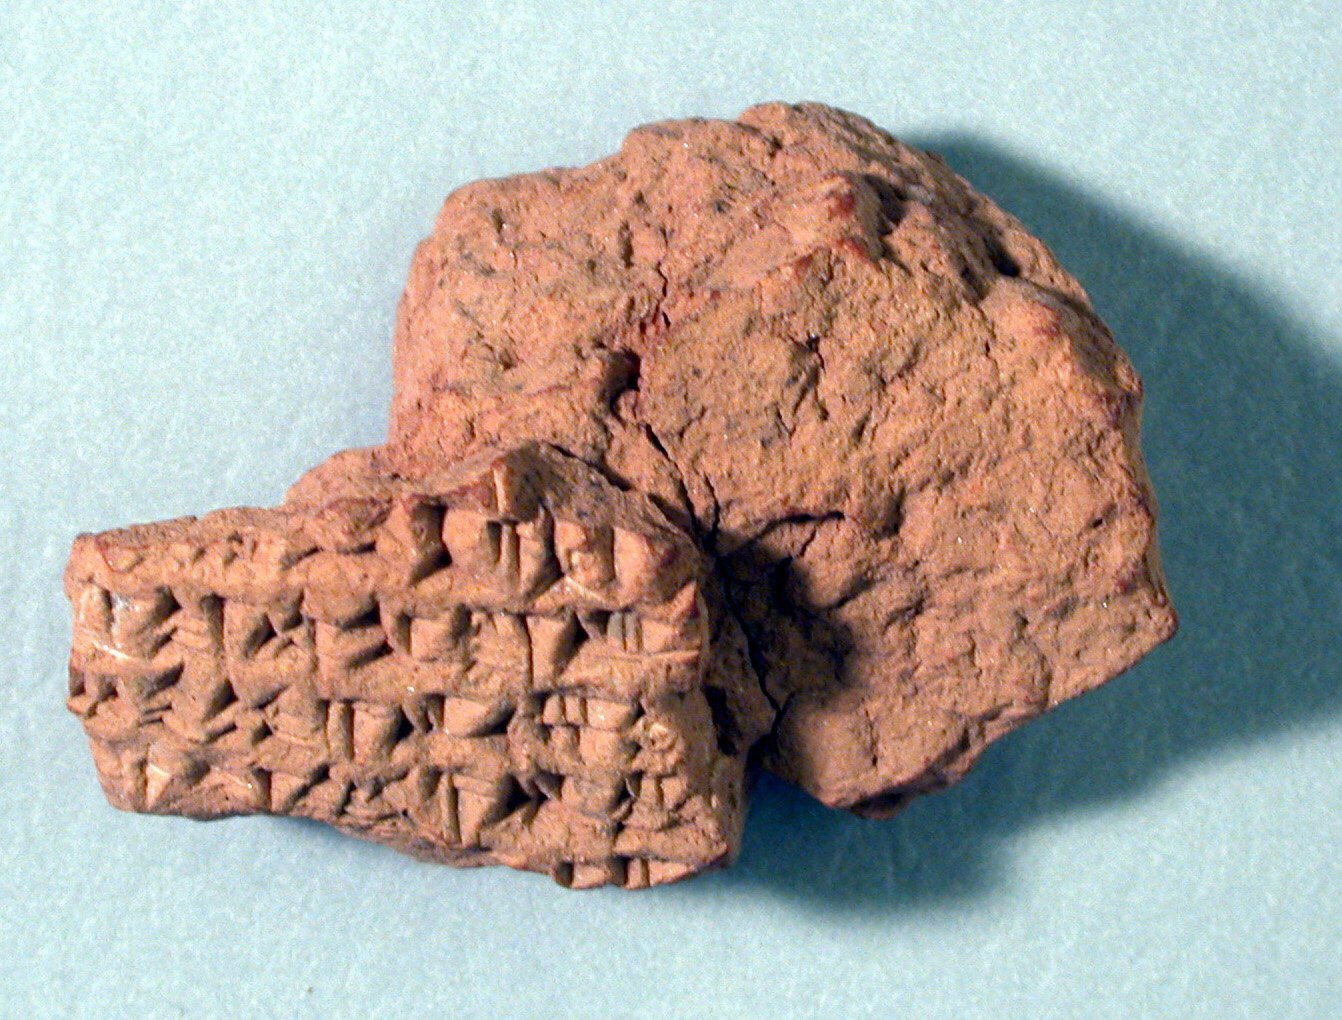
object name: cuneiform tablet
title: Cuneiform tablet: fragment of a contract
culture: achaemenid or babylonian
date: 700-301 BCE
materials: clay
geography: mesopotamia